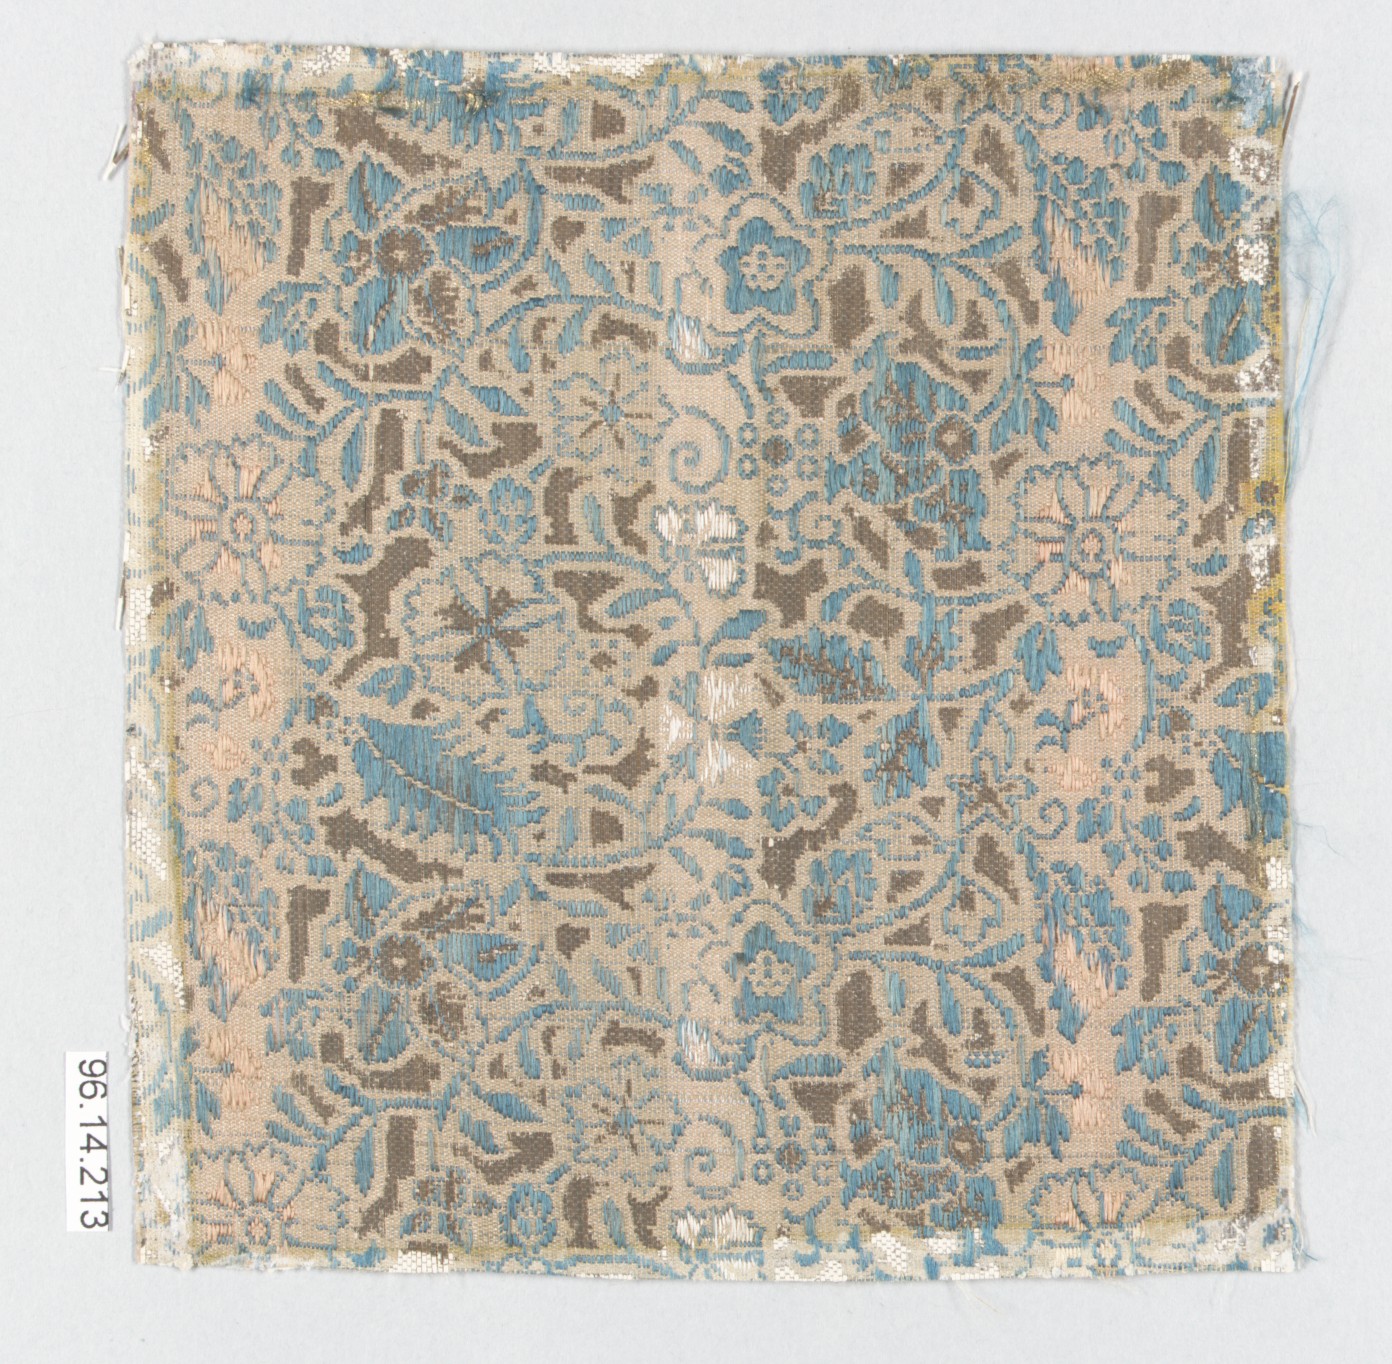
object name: piece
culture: japanese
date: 1701-1900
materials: silk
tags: leaves